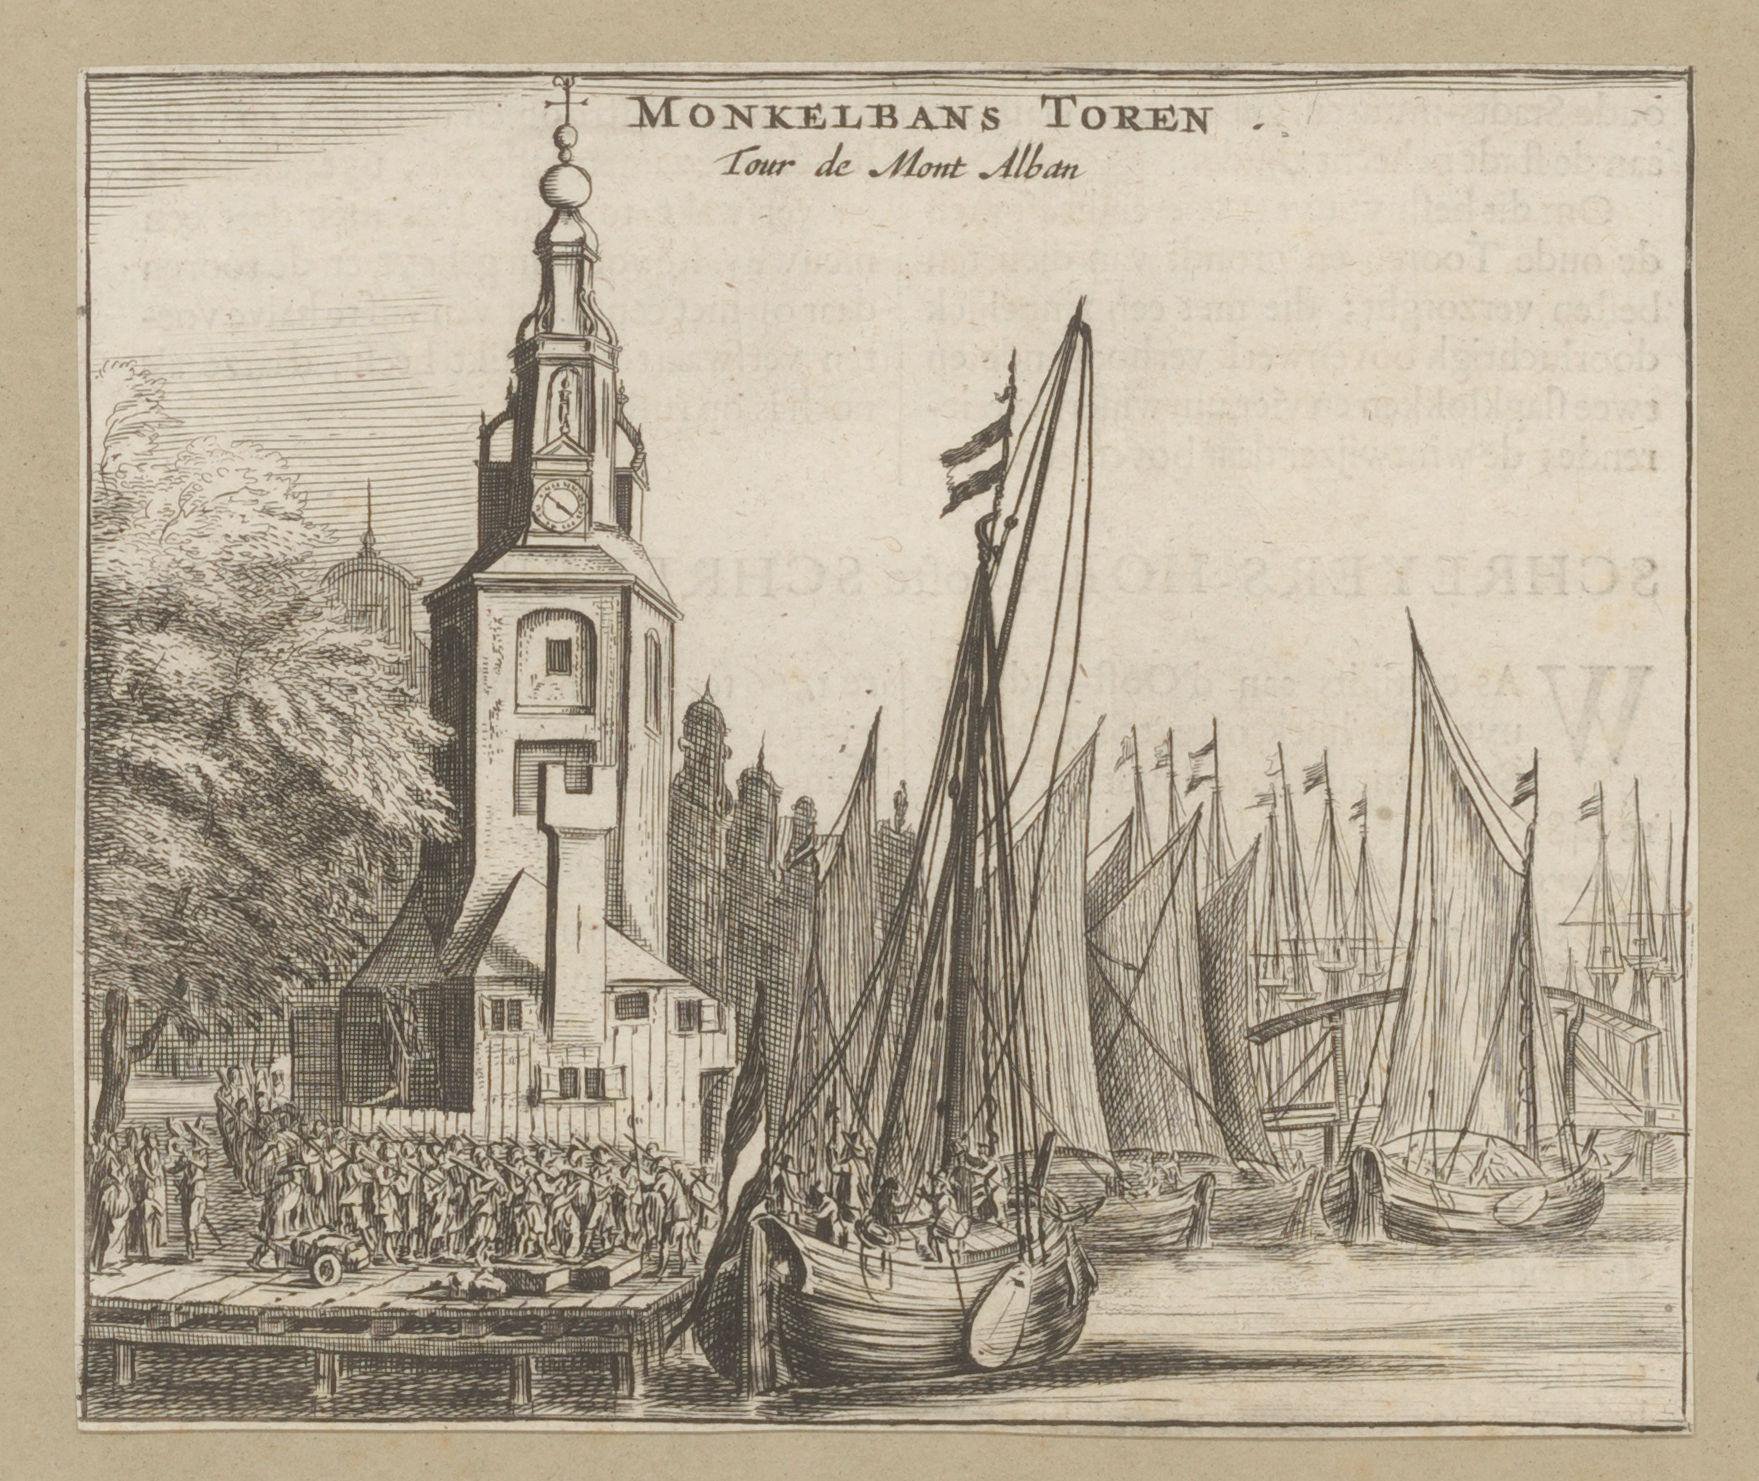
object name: book illustration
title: Monkelbans Toren / Tour de Mont Alban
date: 1665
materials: paper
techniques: engraving, etching, letterpress printing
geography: amsterdam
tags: sailing-ship, sailing-boat, tower, clock tower ~ monumental adornment, canals, waters (in city) (+ city(-scape) with figures, staffage)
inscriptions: collector's mark: Lugt 1641b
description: Prent uit: Domselaer, Tobias en Isaac Commelin. Beschryvinge van Amsterdam (…). 6 dln. Amsterdam: Marcus Willemsz. Doornick, 1665, dl. 4, p. 261.